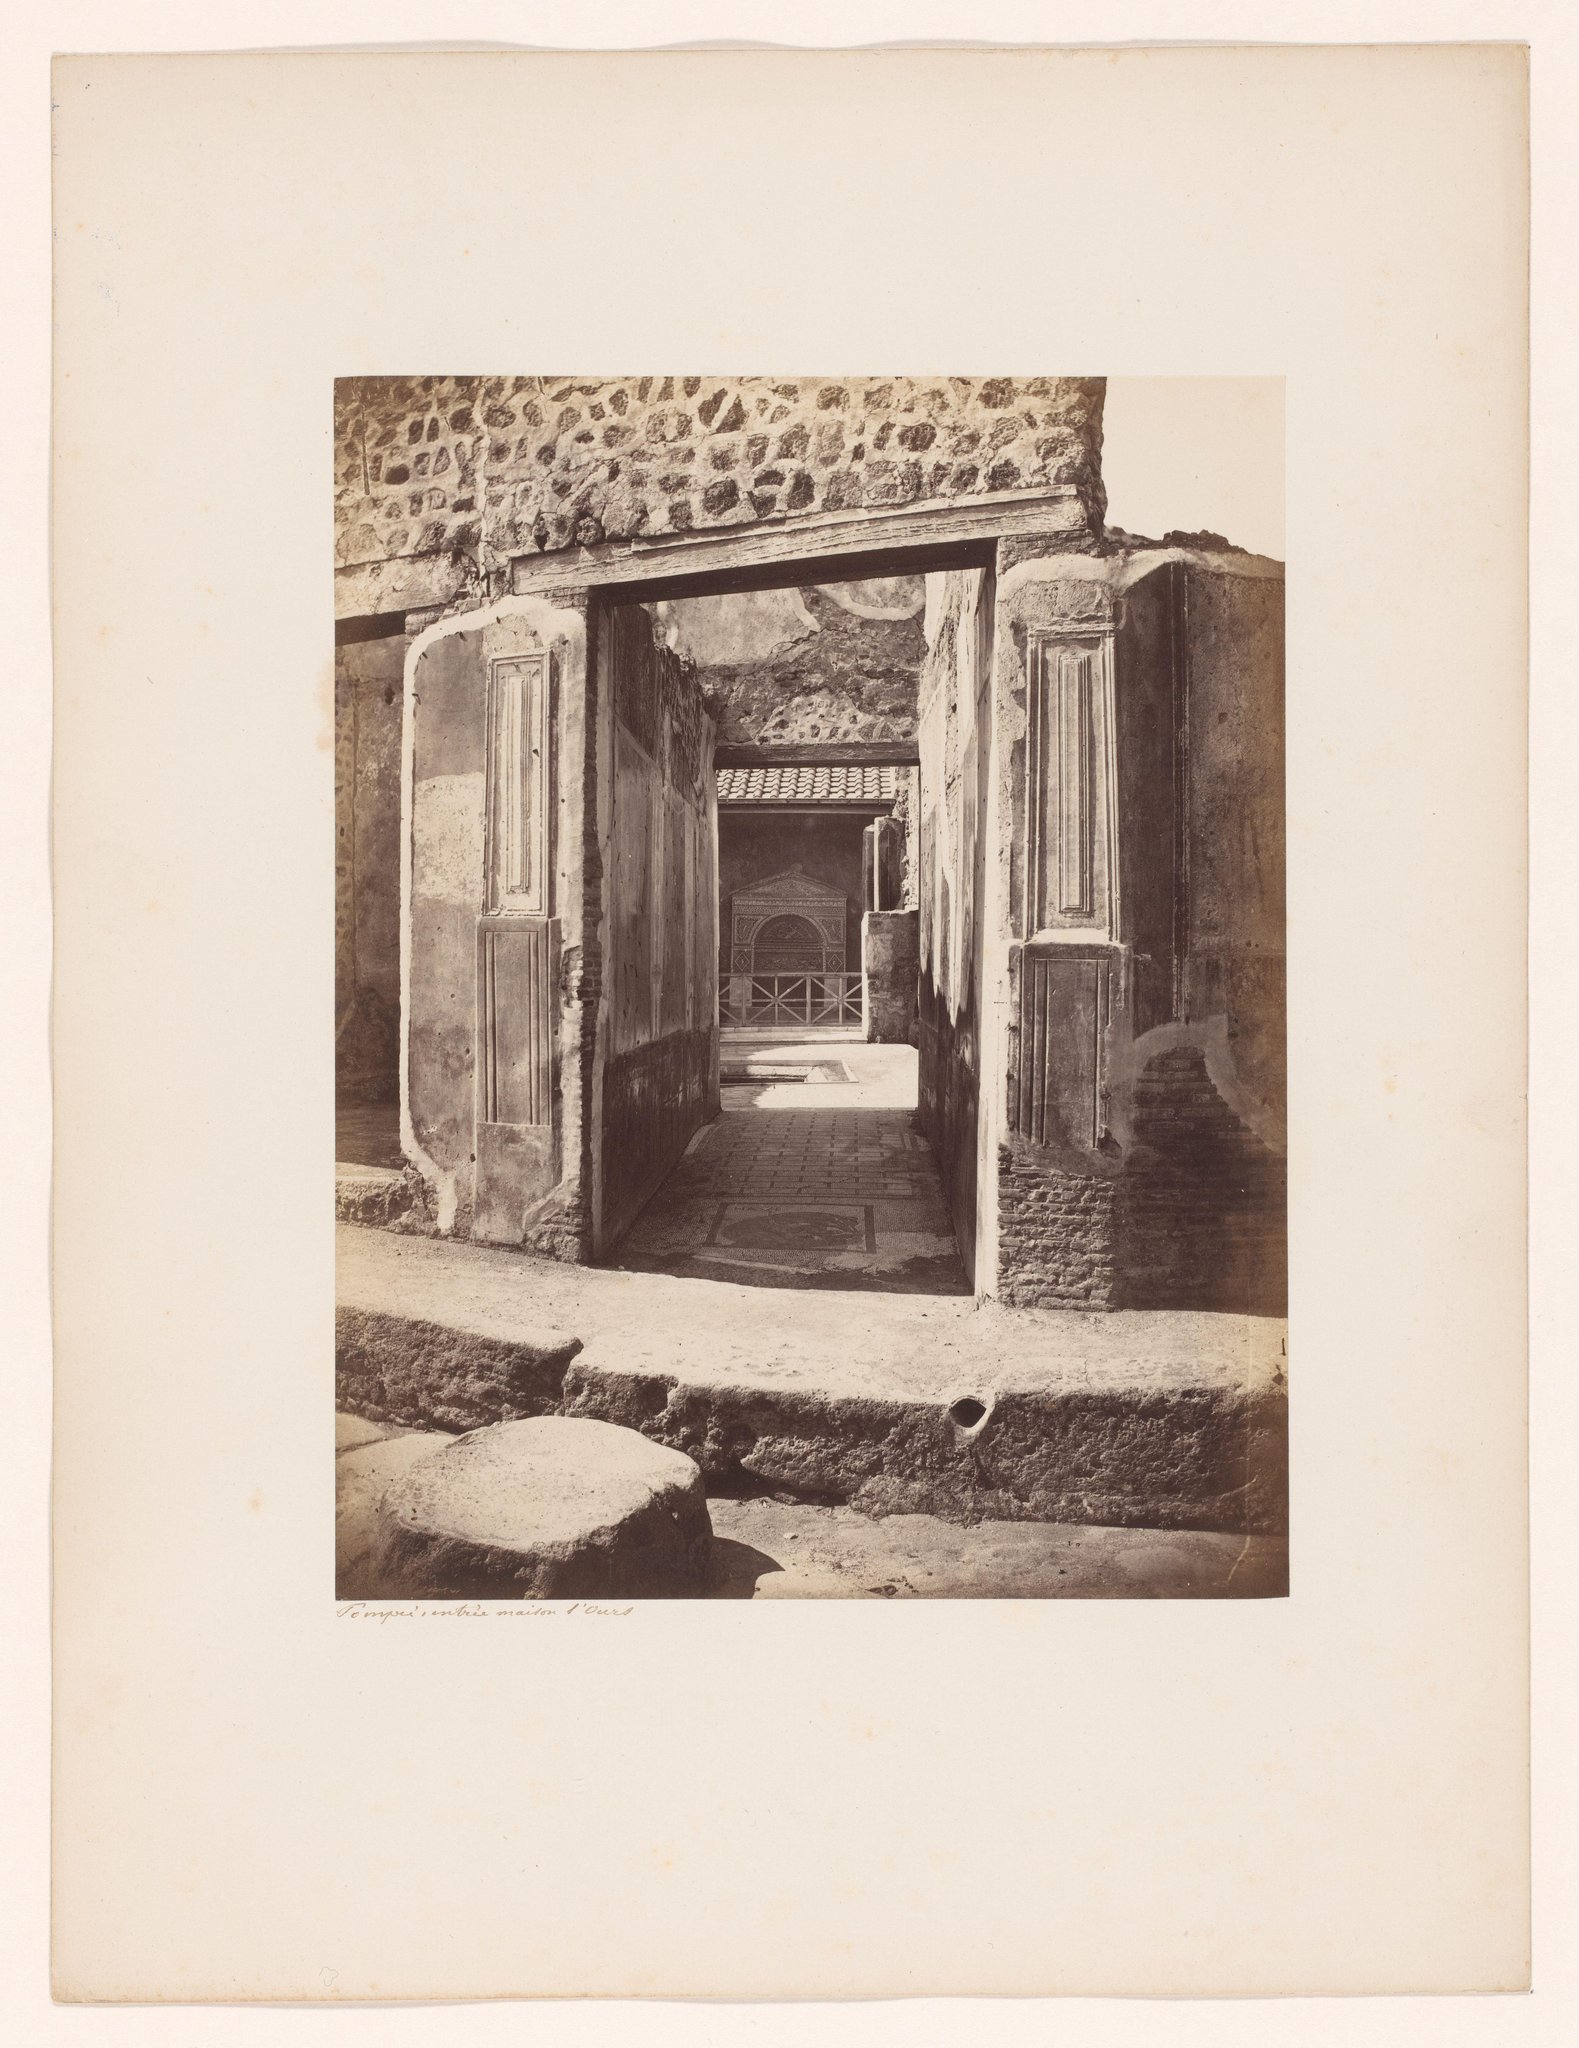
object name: photograph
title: Pompei, entrée maison l'Ours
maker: giorgio sommer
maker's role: fotograaf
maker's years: 1834-1914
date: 1857-1914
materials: cardboard, paper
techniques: albumen print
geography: pompeii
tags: excavation ~ archaeology, ruin of a dwelling, house, castle, etc., pompeii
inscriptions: number: ‘10’, number: ‘45’